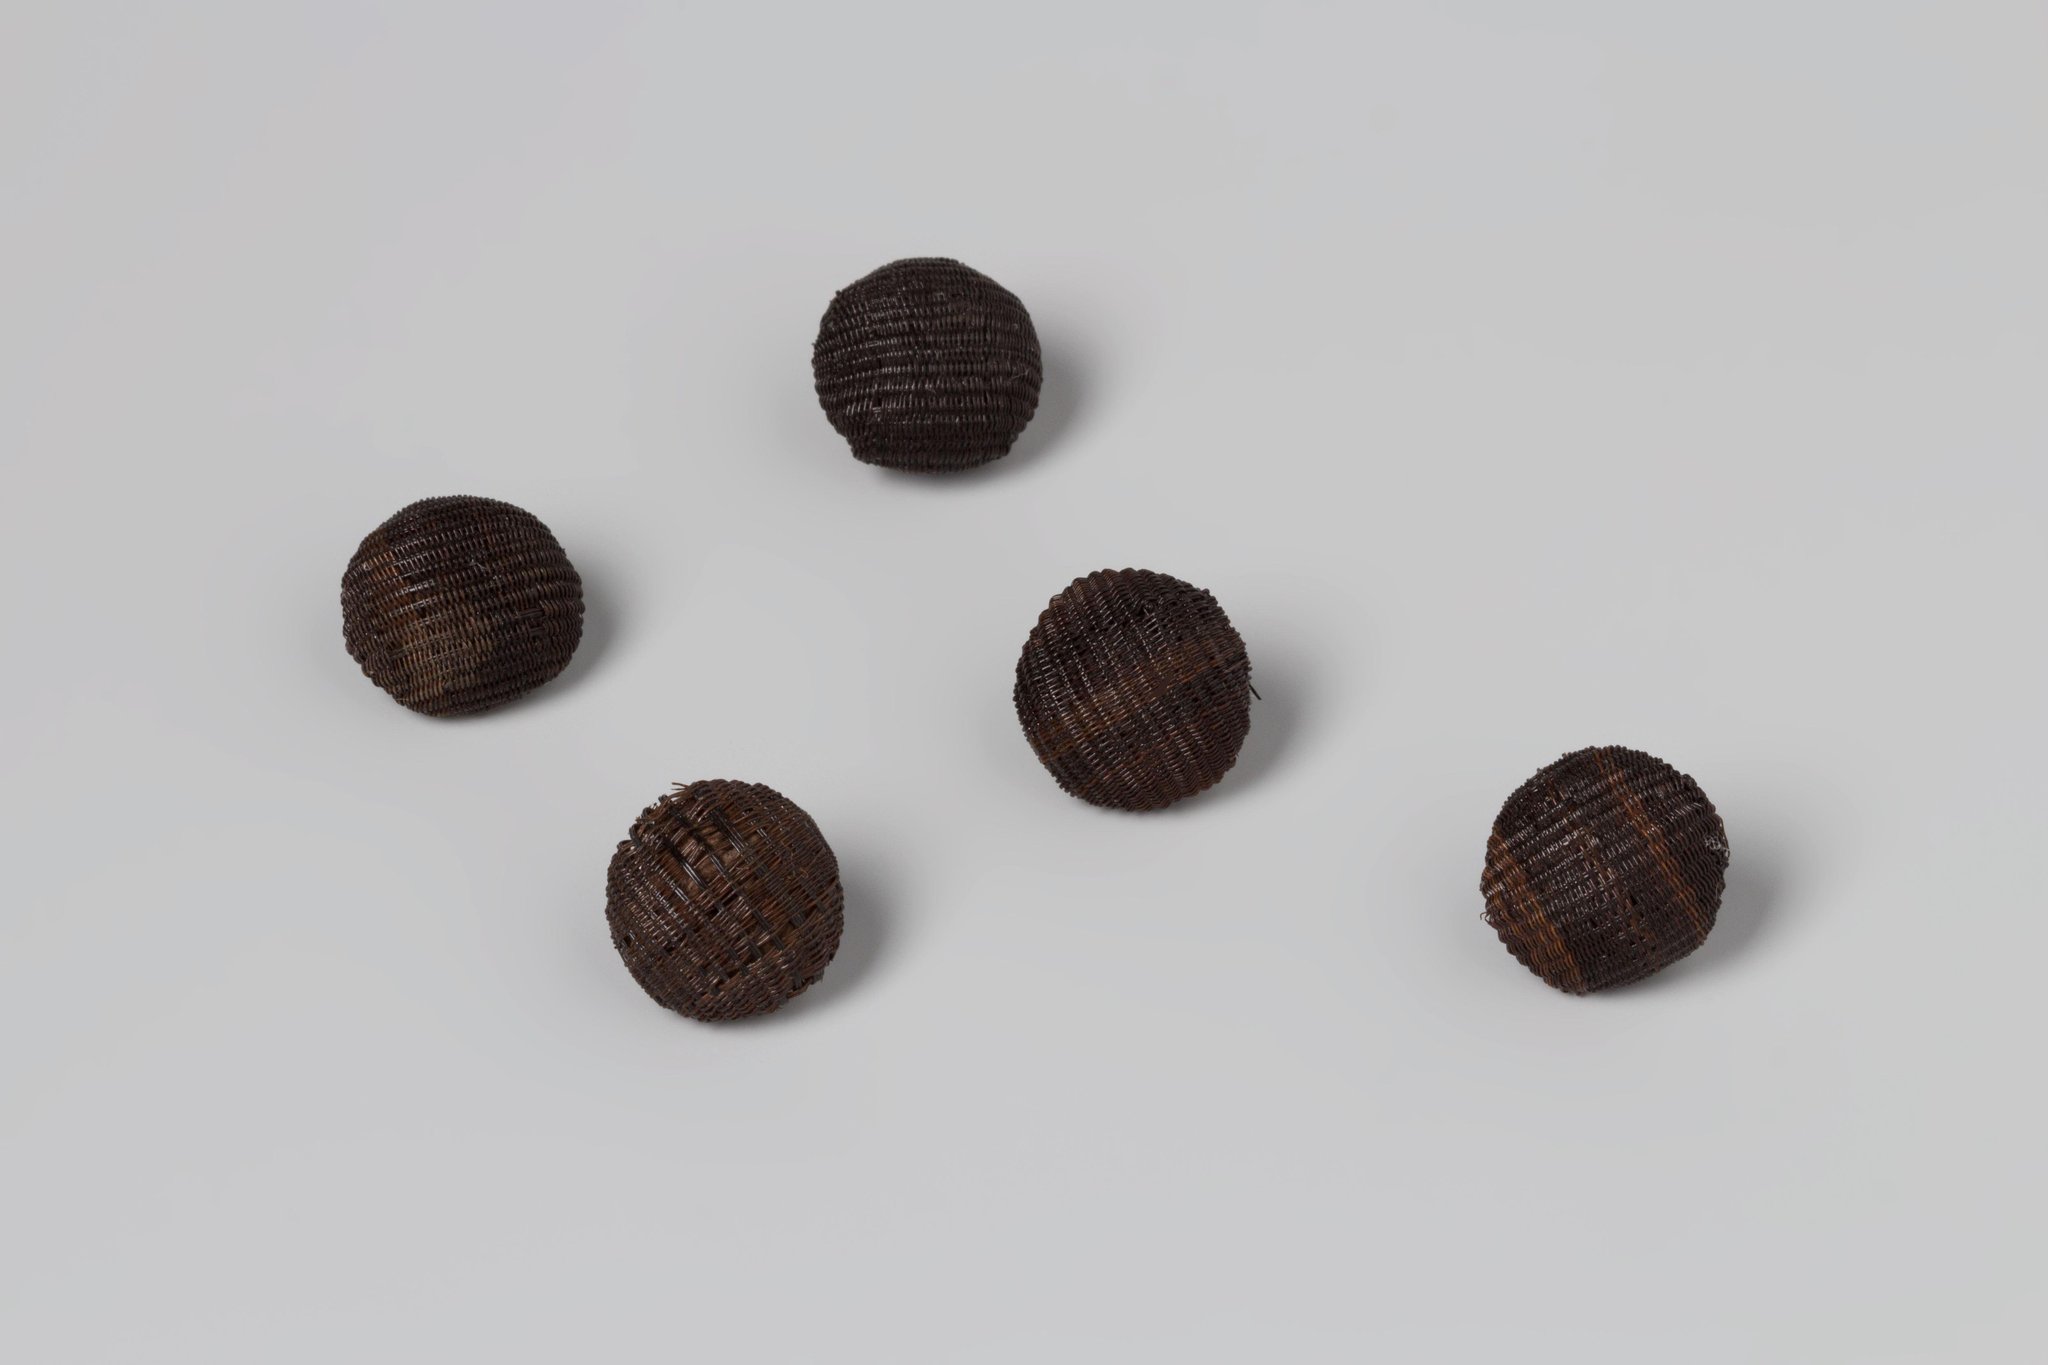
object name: button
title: 5 knopen horend bij een jas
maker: Anonymous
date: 1740-1760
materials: wool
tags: noordse compagnie, spitsbergen, zeeuwsche uytkyck, svalbard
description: 5 knopen horend bij een jas. De knopen zijn identiek en bekleed met zwart textiel.